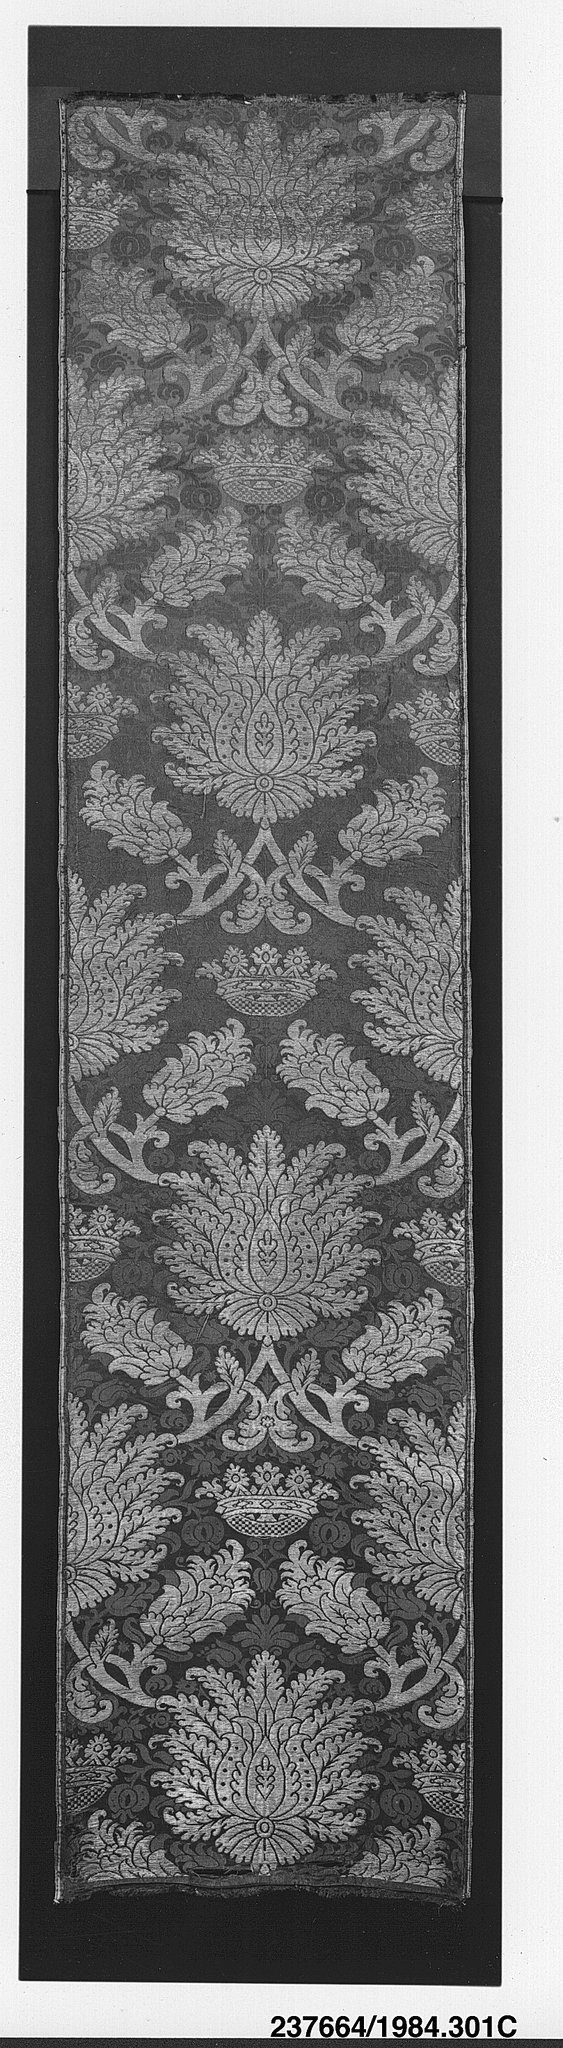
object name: panel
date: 1601-1700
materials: metal thread, silk